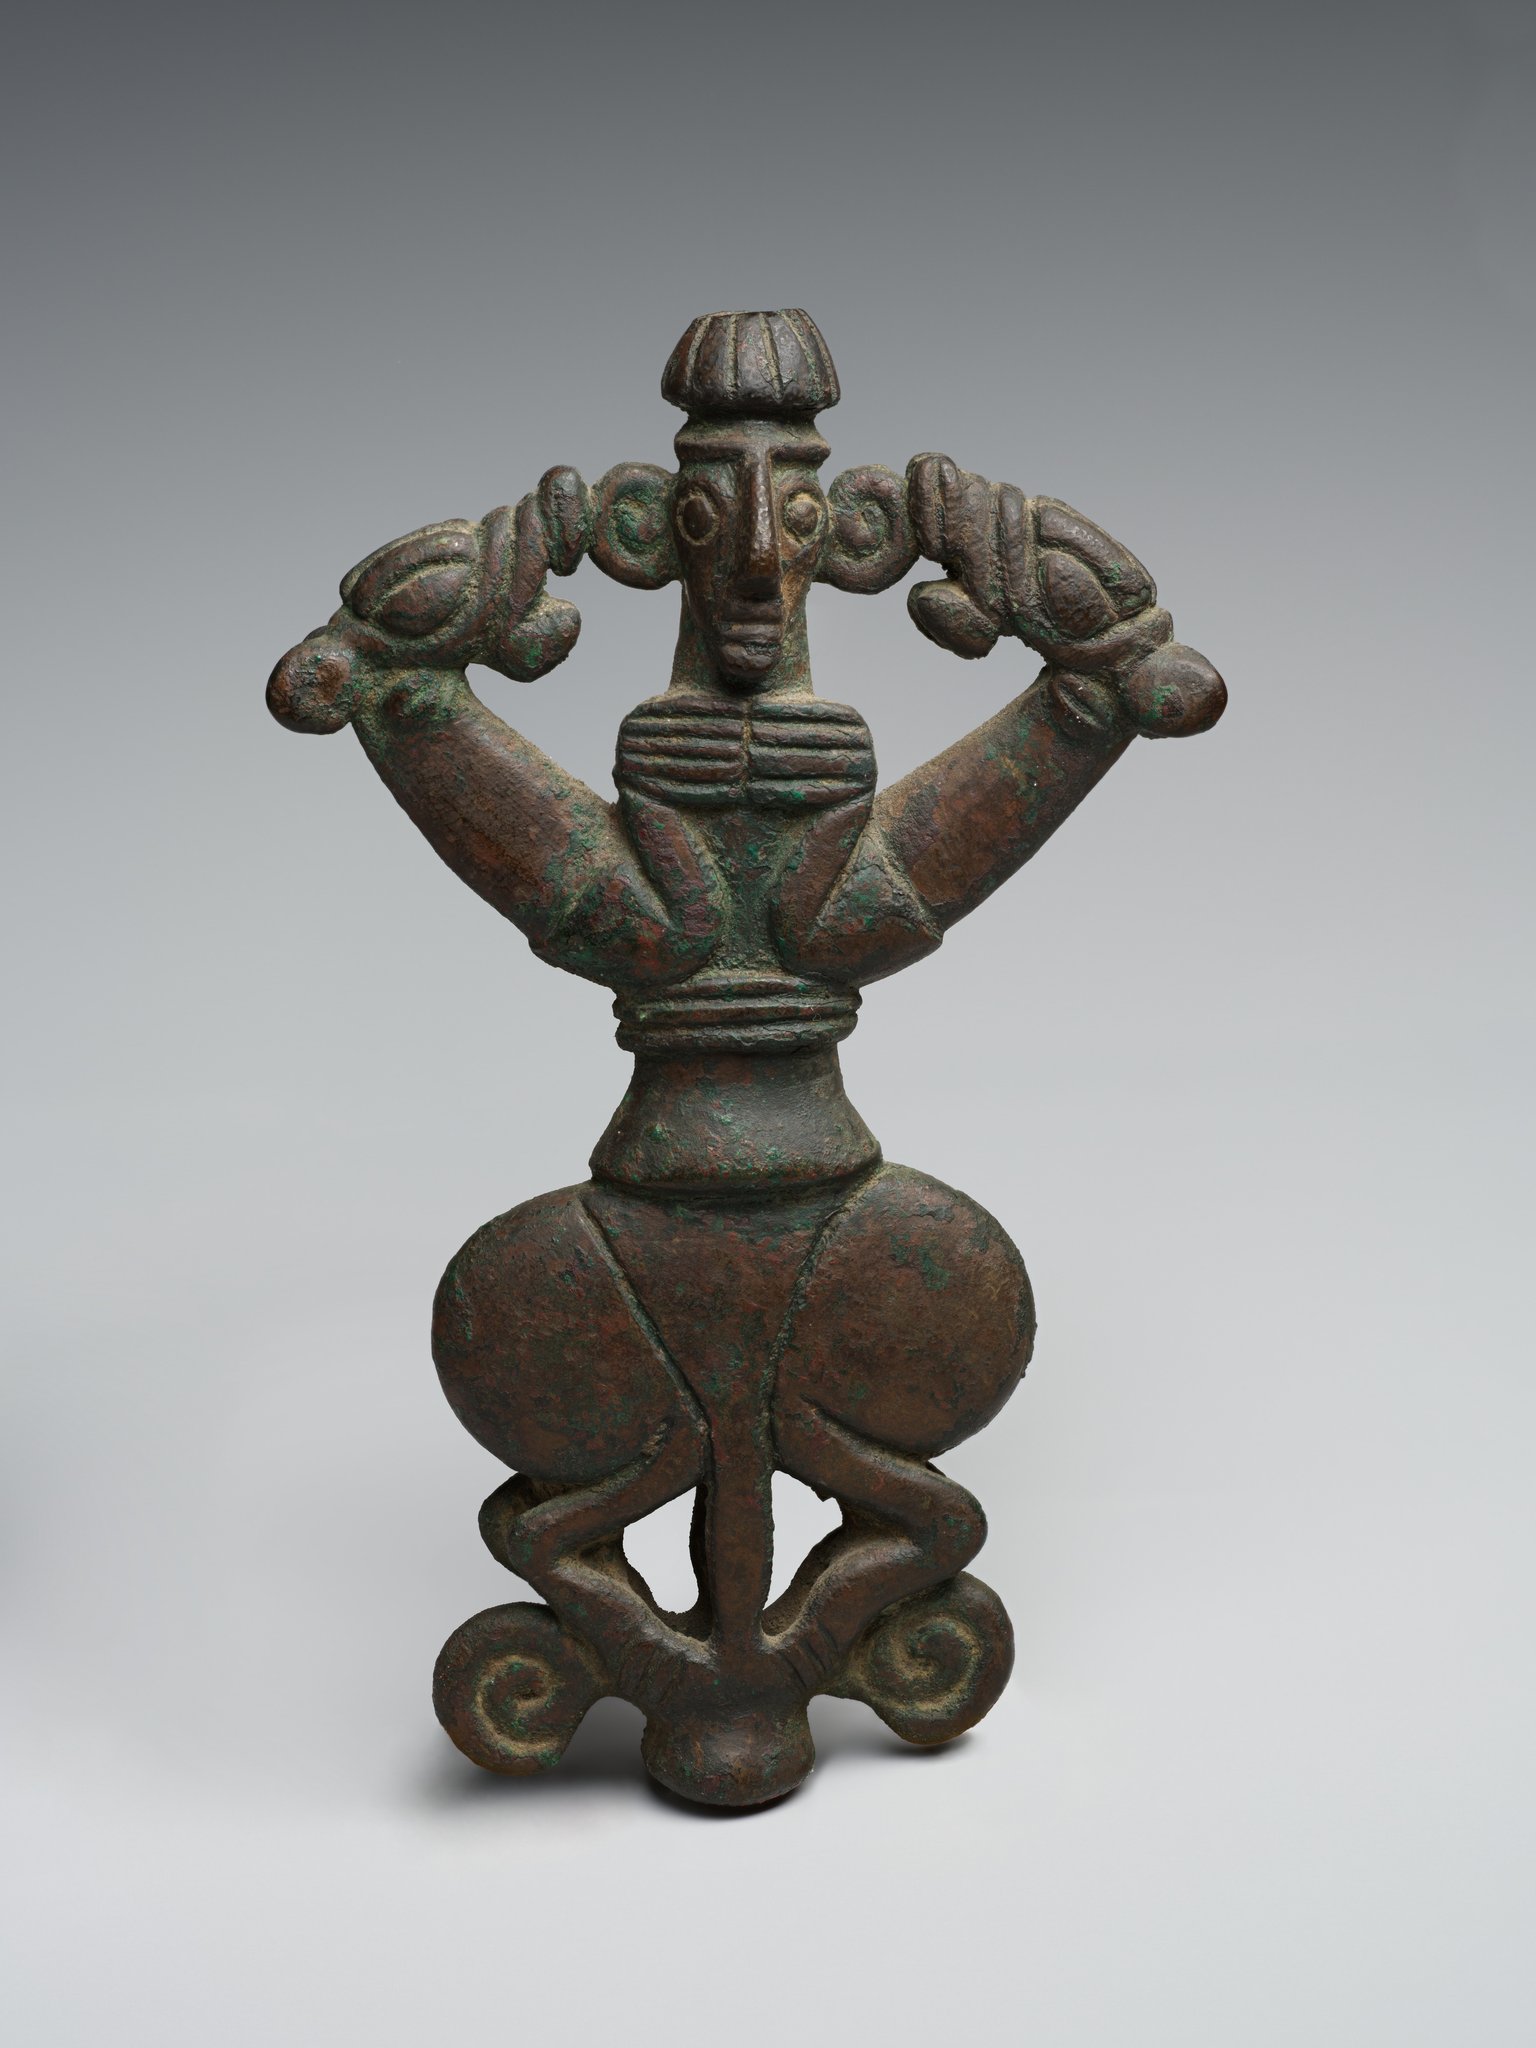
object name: standard top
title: Top for standard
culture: iranian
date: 1000-1 BCE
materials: bronze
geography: iran, probably from luristan